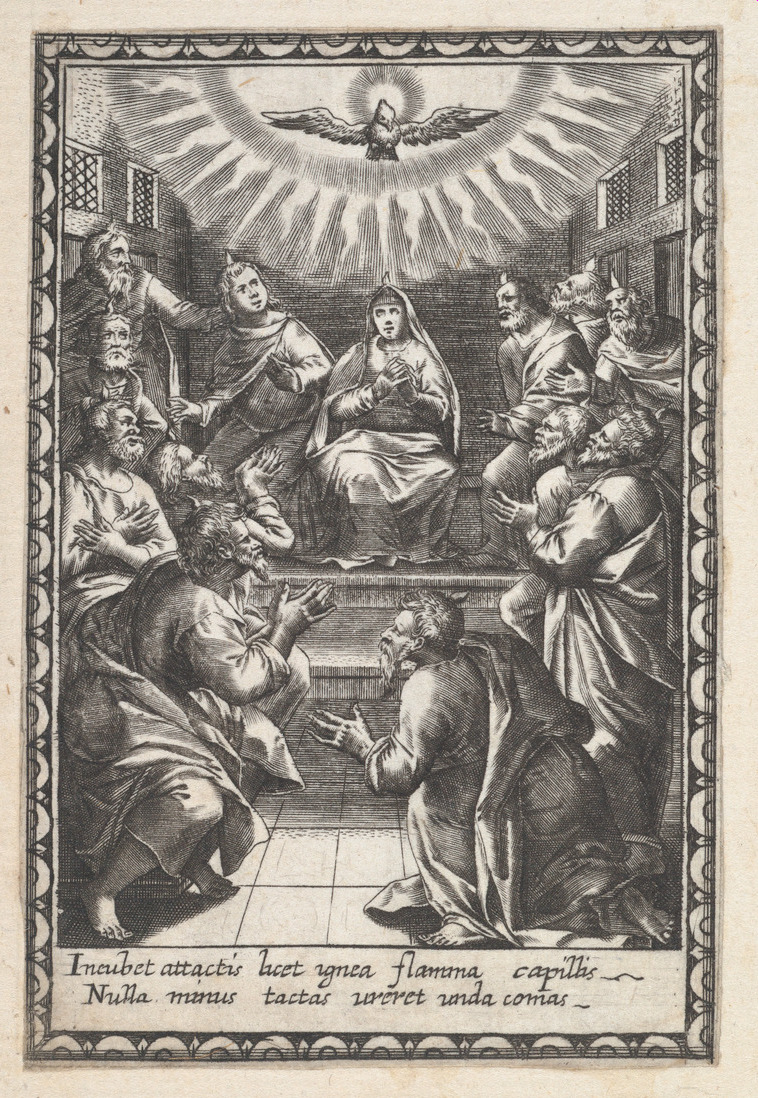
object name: print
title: Pentecost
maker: Anonymous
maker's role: artist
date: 1578-1620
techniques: engraving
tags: doves,men,apostles,virgin mary,pentecost